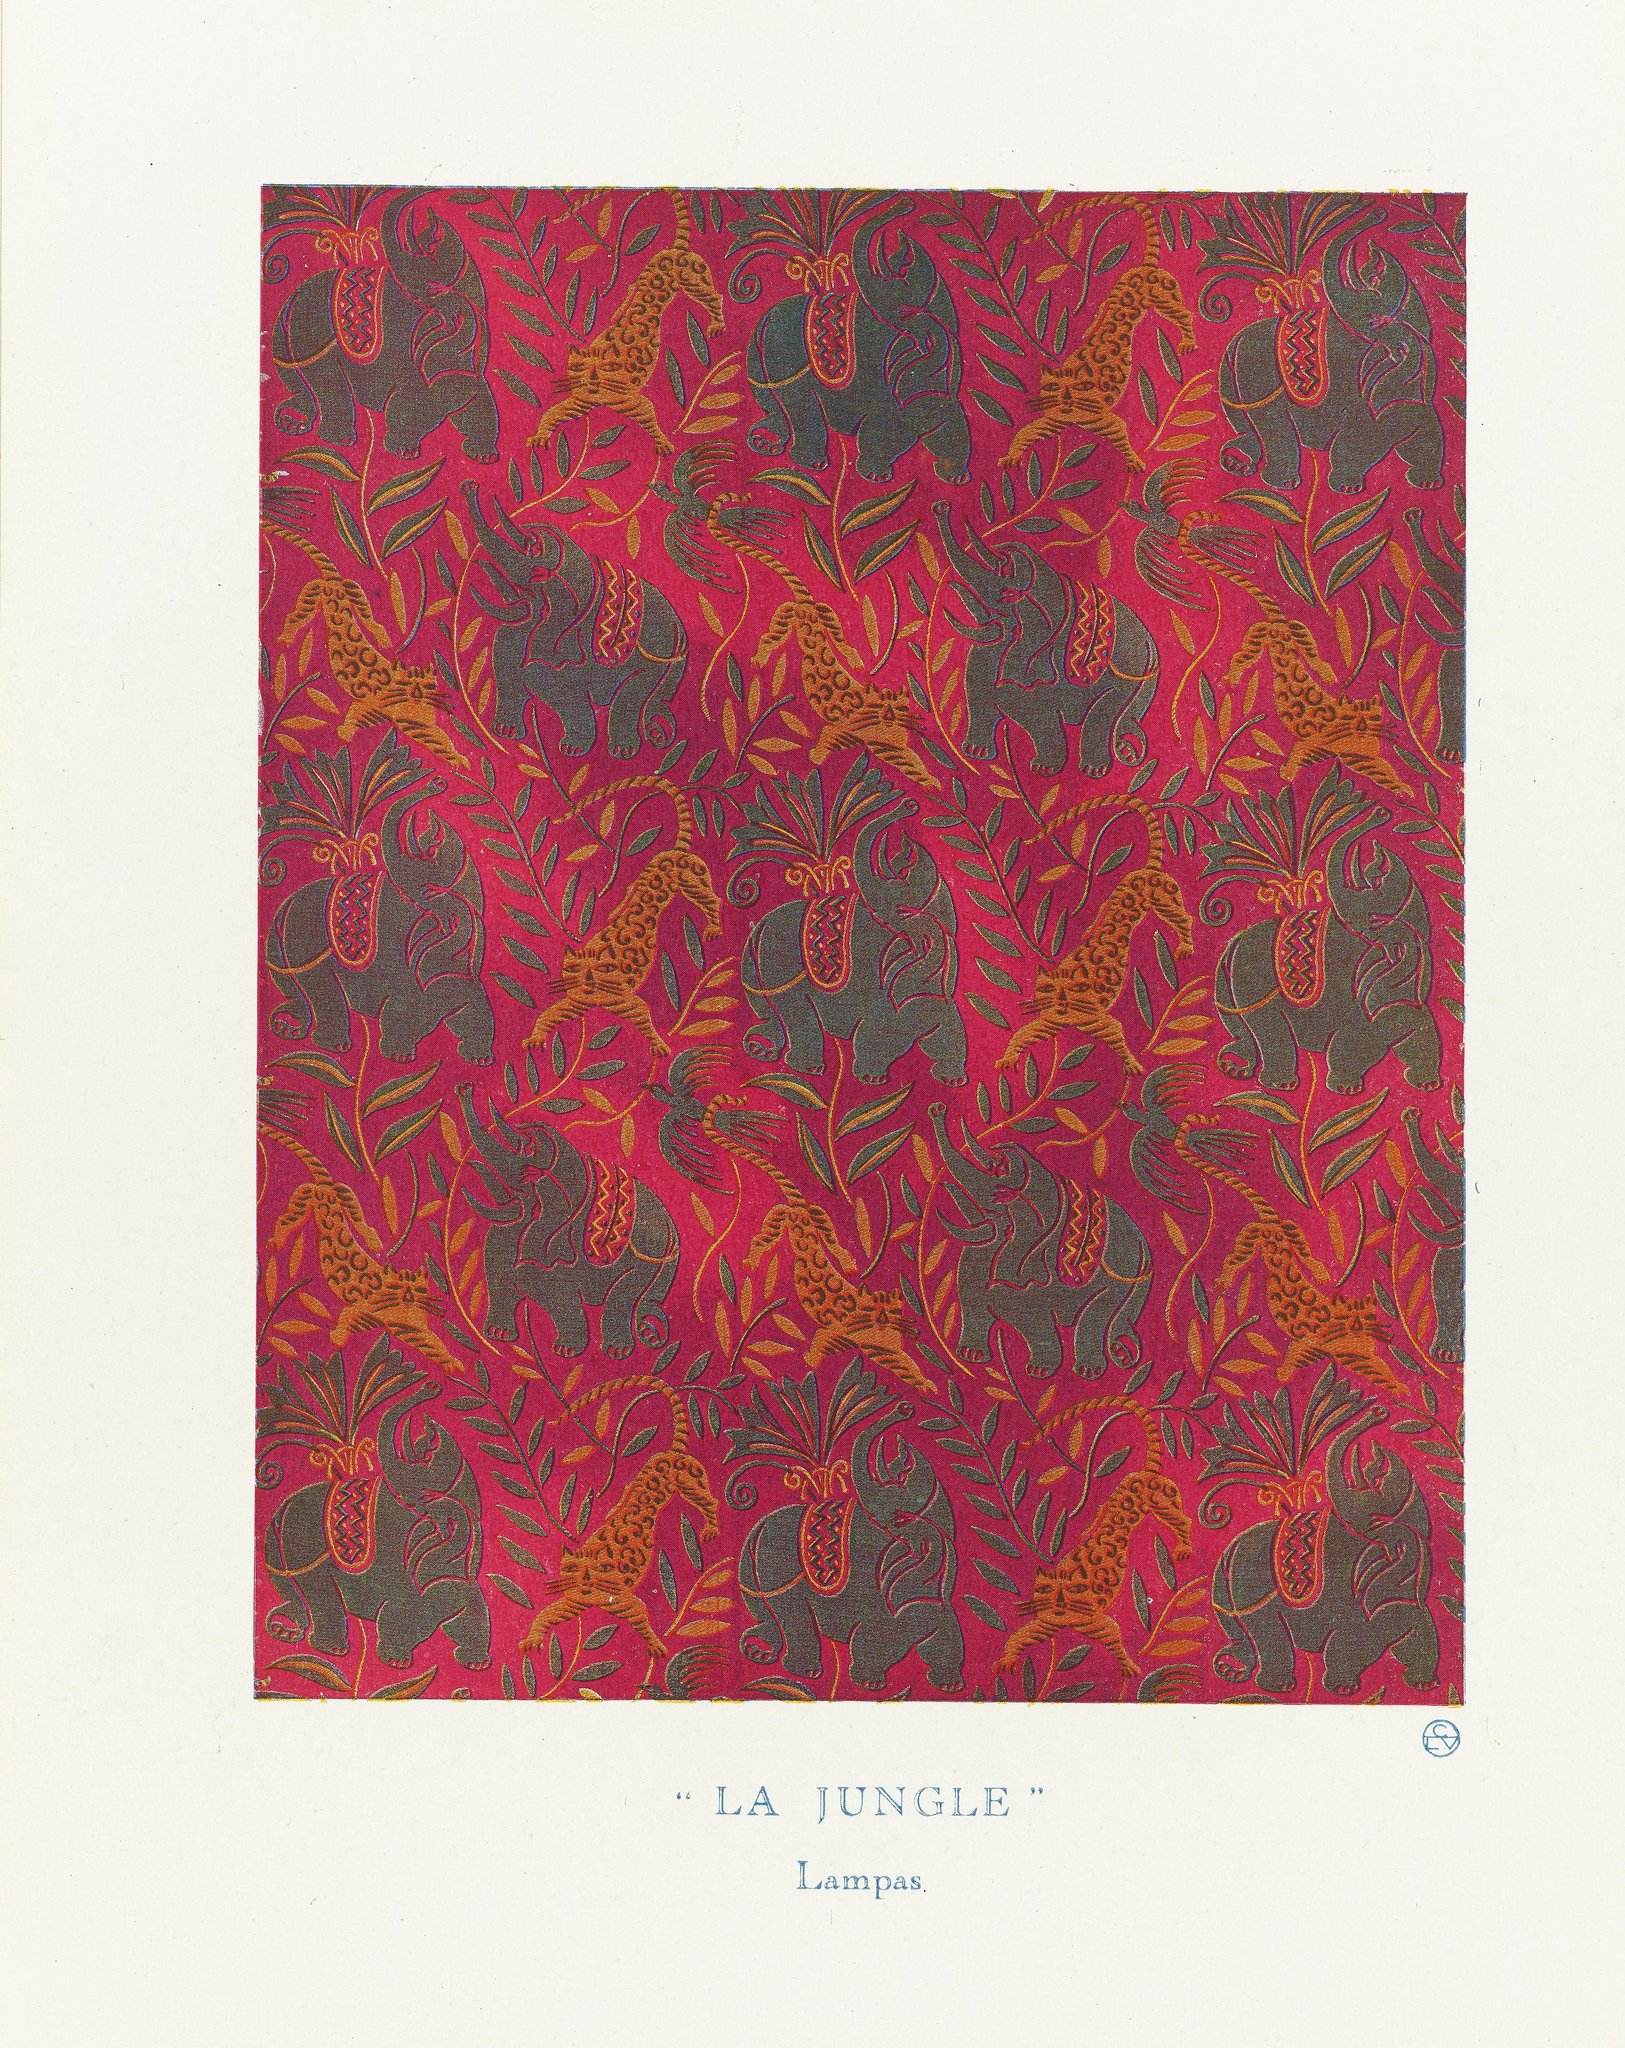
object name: fashion print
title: Gazette du Bon Ton, 1920 - No. 8, Pl. XL: "La jungle "/ Lampas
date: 1920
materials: paper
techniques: printing, letterpress printing, photochemical processes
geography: london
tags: beasts of prey, predatory animals: panther, textile fabric, cloth (+ plan, design ~ production), fashion plates, trunked animals: elephant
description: Stofpatroon met olifanten en panters. De stof is ontworpen door Raoul Dufy. en gemaakt door de bekende zijdefabrikant Bianchini Férier, bij wie Dufy tussen 1912 en 1928 als ontwerper in dienst was. Mede door deze samenwerking werd hij een van de belangrijkste stofontwerpers van de 20ste eeuw. De prent maakt deel uit een serie van vier ontwerpen voor meubelstoffen, getiteld: 'Toiles de tournon lampas, brocarts et brocatelles.' Planche XL uit Gazette du Bon Ton 1920, No. 8. Uitleg over de stoffen op pagina "Explication des Planches".